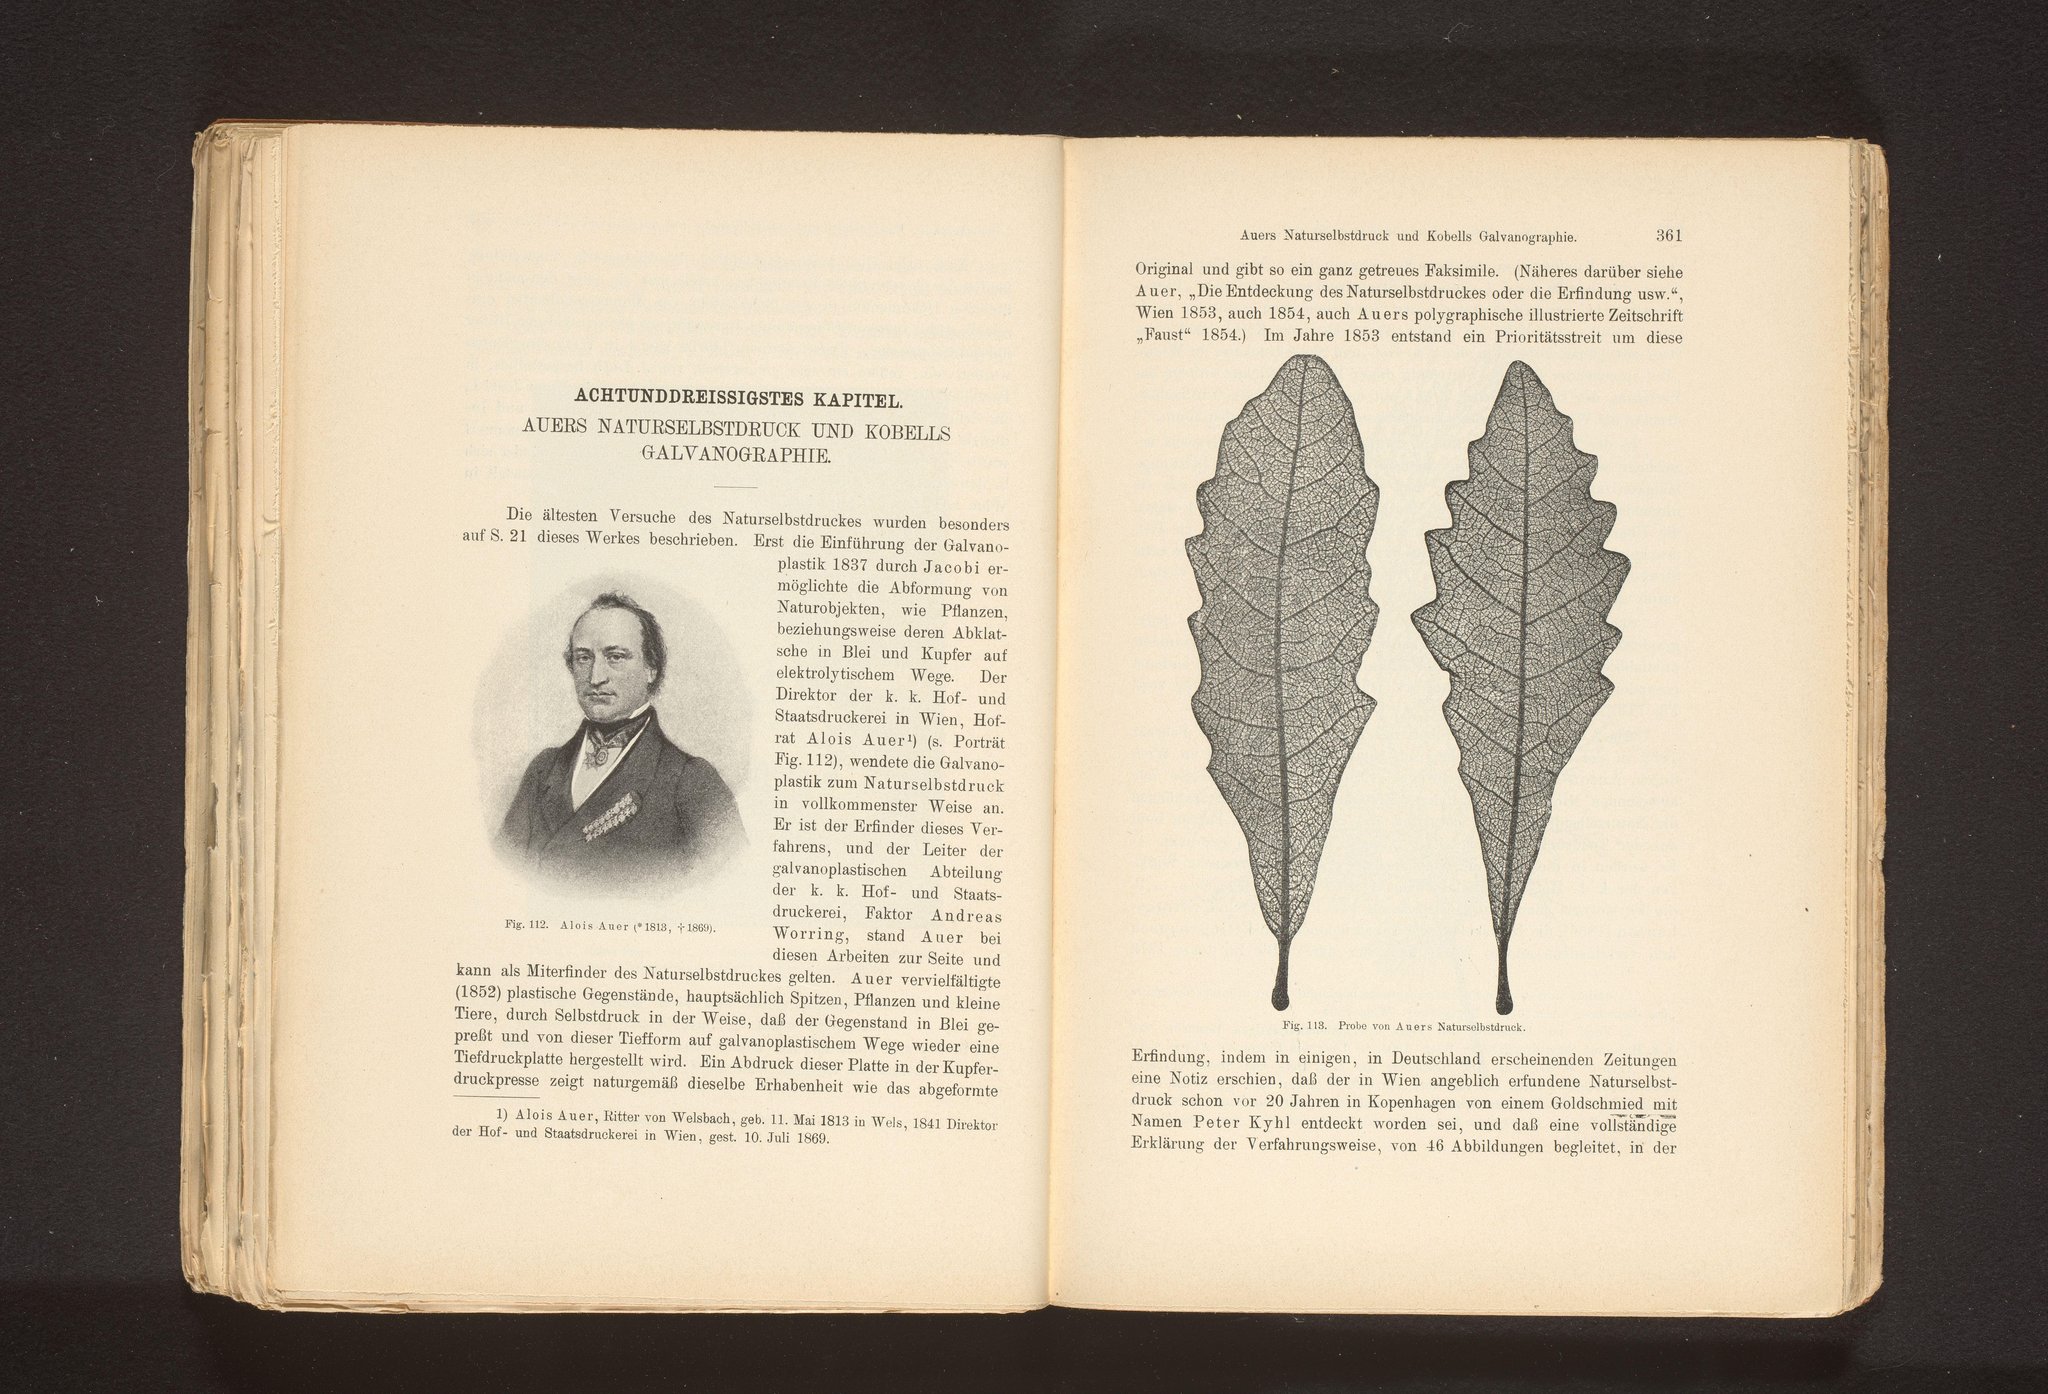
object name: photomechanical print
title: Twee eikenbladeren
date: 1900-1905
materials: paper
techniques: autotype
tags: trees: oak (+ leaf)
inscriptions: number: ‘Fig. 113.’